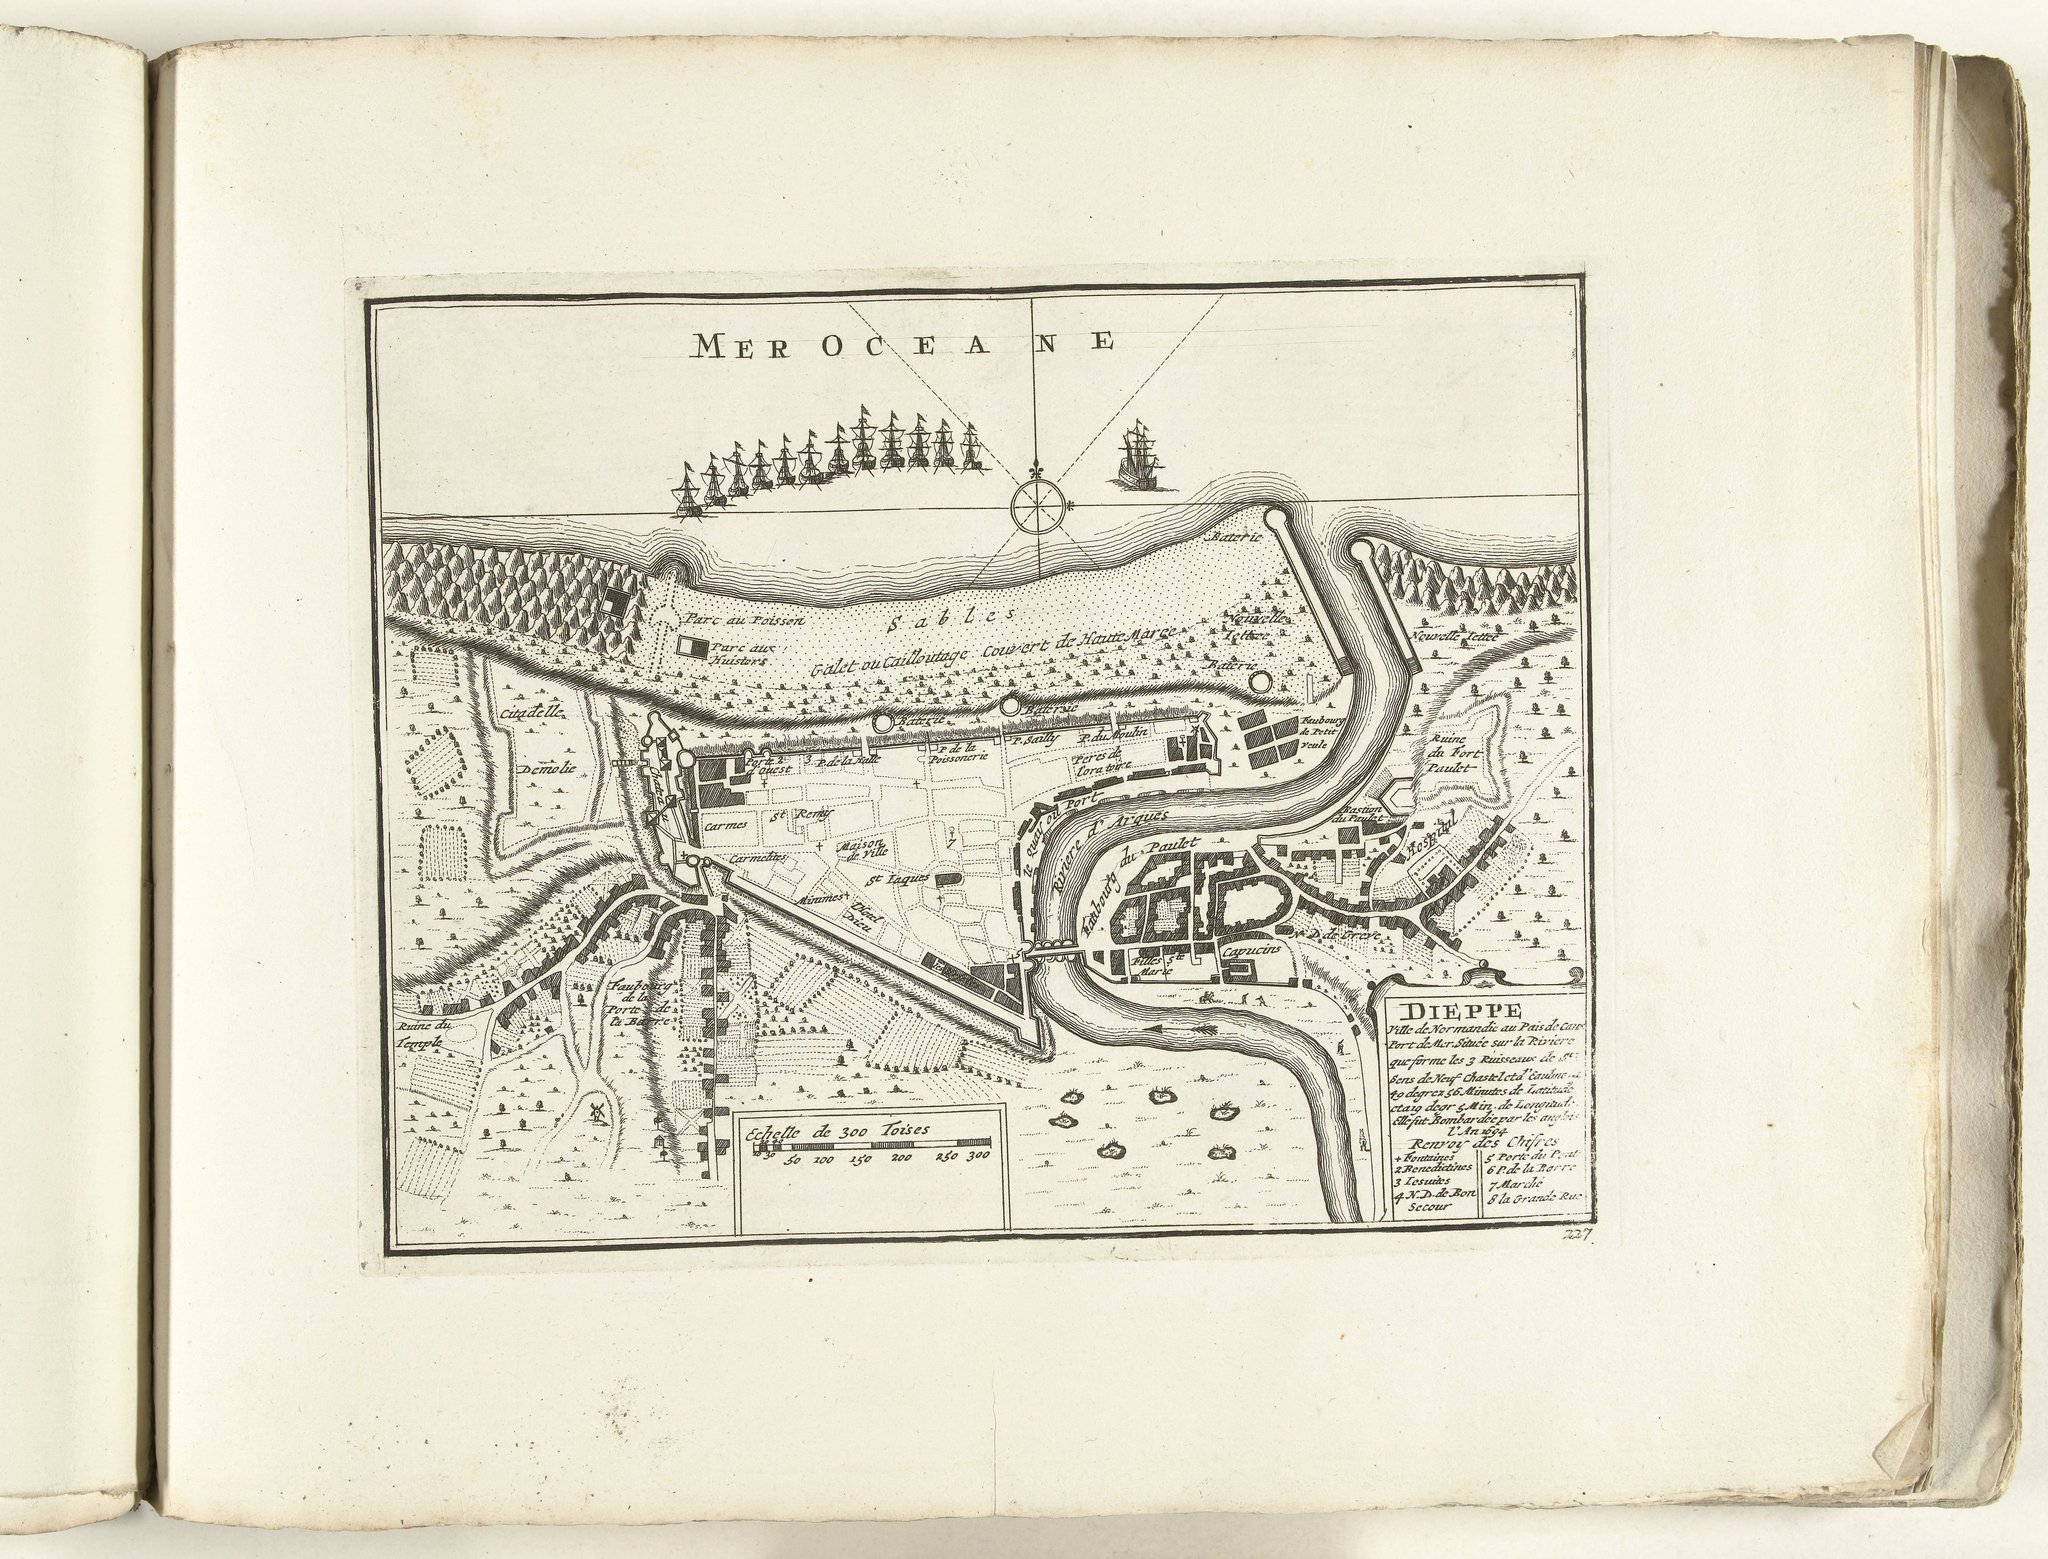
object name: print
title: Dieppe Ville de Normandie (...) Elle fut Bombardee par les anglois l'An 1694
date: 1702-1703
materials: paper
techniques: etching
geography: northern netherlands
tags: maps of cities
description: Plattegrond van de Franse havenstad Dieppe, gebombardeerd door de geallieerden in juli 1694. Plaat nr. 227 in het prentwerk bestaande in totaal uit 276 genummerde platen van vermaarde sterke steden en vestingen in het kader van de Spaanse Successieoorlog. Voor het merendeel zijn deze platen gekopieerd naar de anonieme Franse platen: in Les forces de l'Europe en in: Le theatre de la guerre, dans les Pays-Bas, beide oorspronkelijk uitgegeven door Nicolas de Fer te Parijs (1693-1697) in het kader van de Negenjarige Oorlog. Titel en opschriften in de plaat in het Frans.